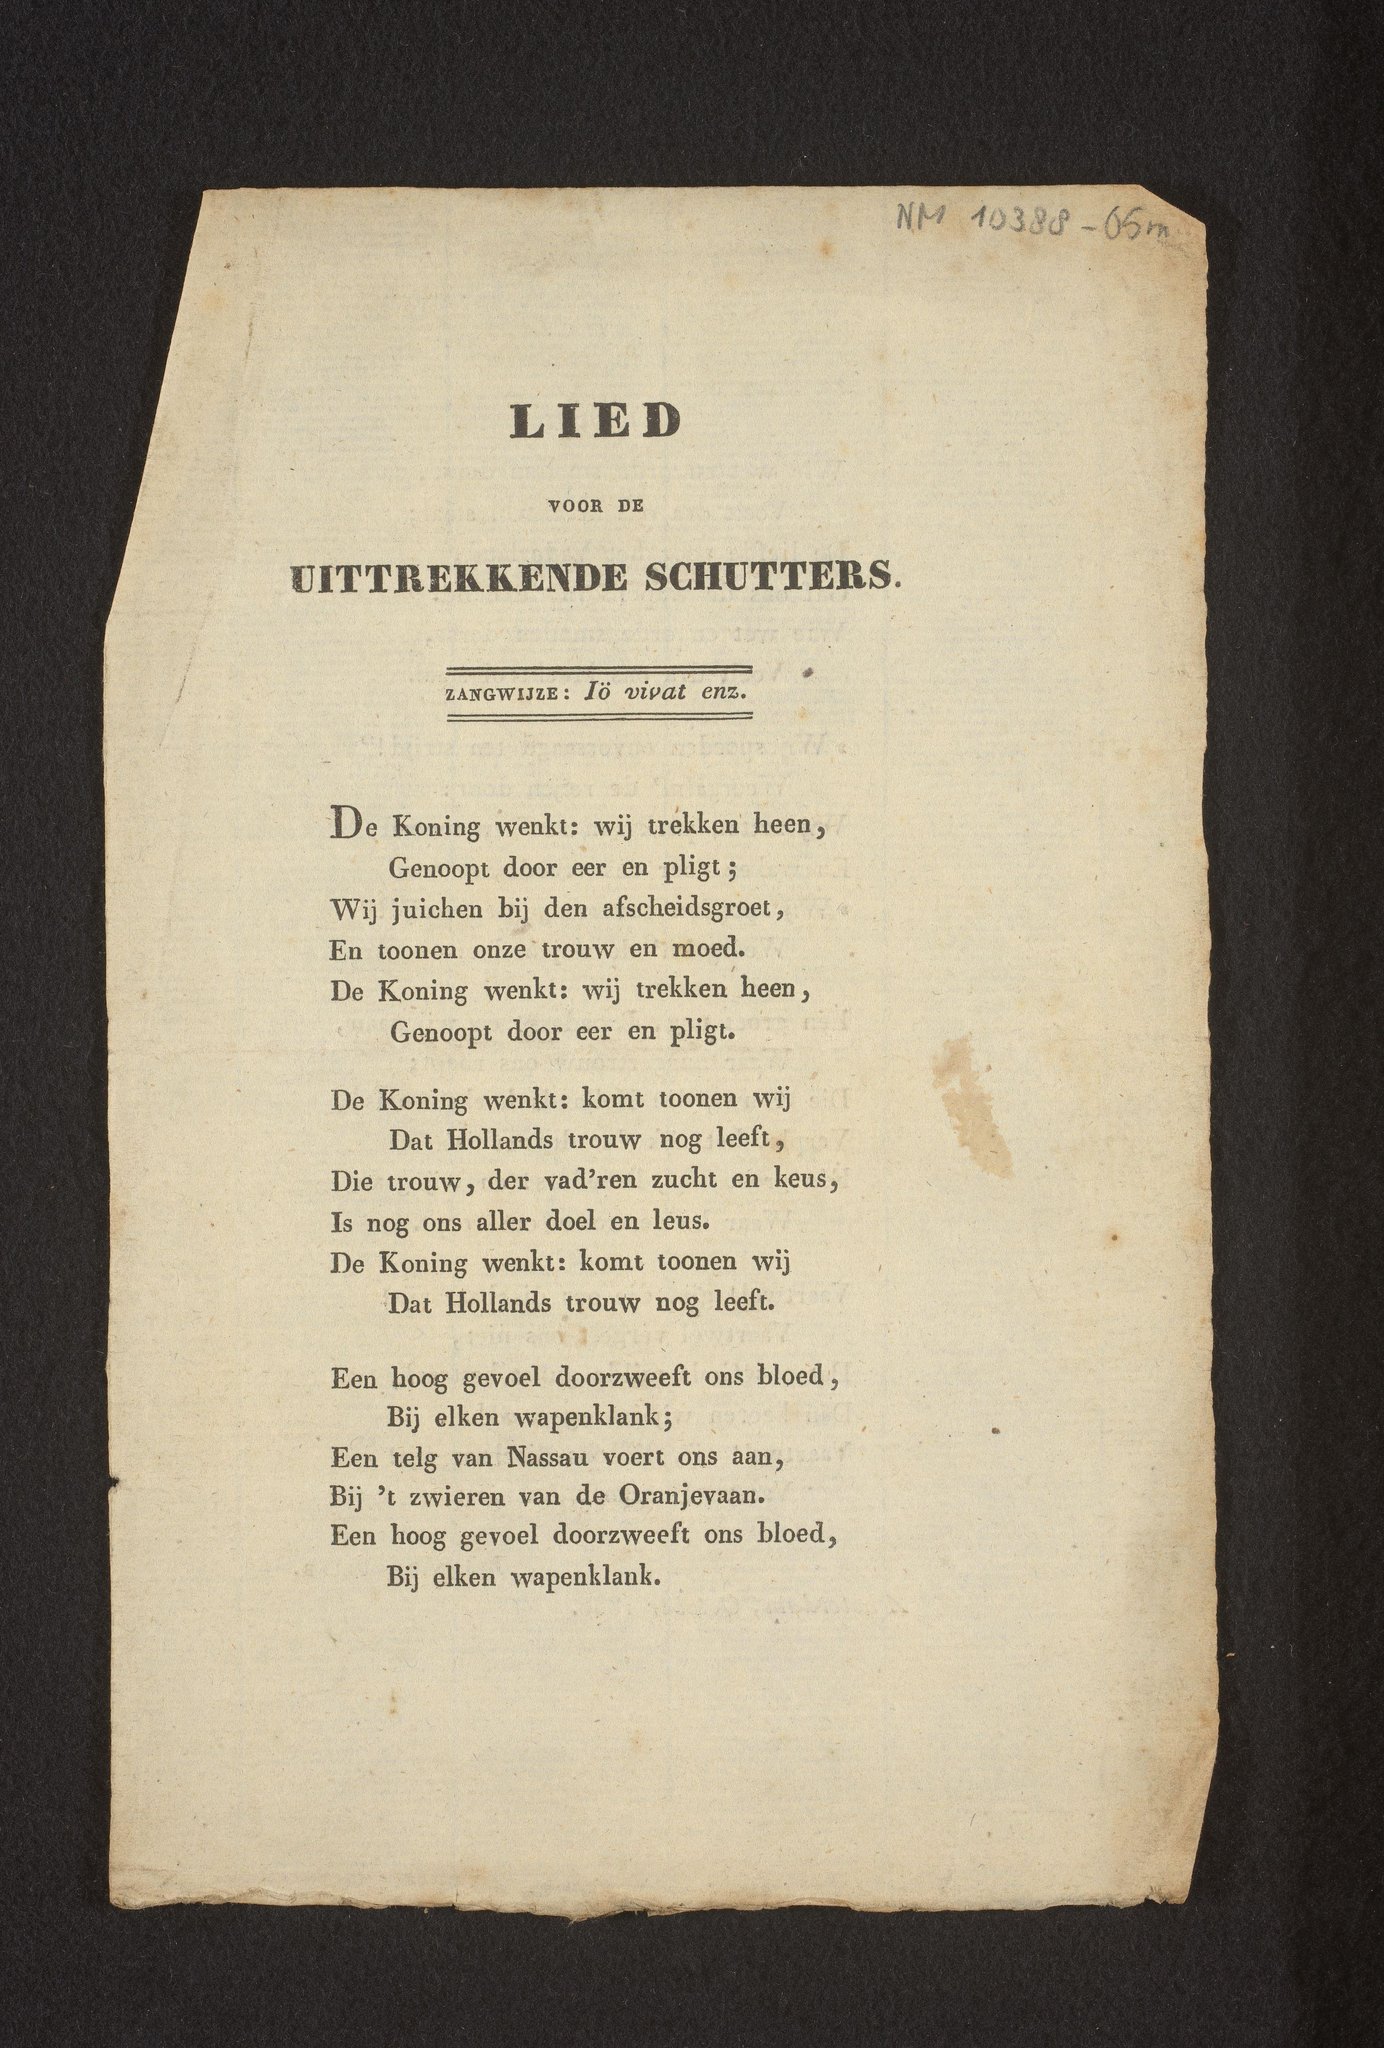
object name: pamphlet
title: Lied voor de Uittrekkende Schutters / Lied voor de Vrijwilligers / Jagerlied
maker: johannes jacobus wijsmuller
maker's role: clockmaker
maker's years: 1806-1882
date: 1830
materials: paper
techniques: printing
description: 6 genummerde pp met 3 gedichten, 1e blad los van pp 3-6.